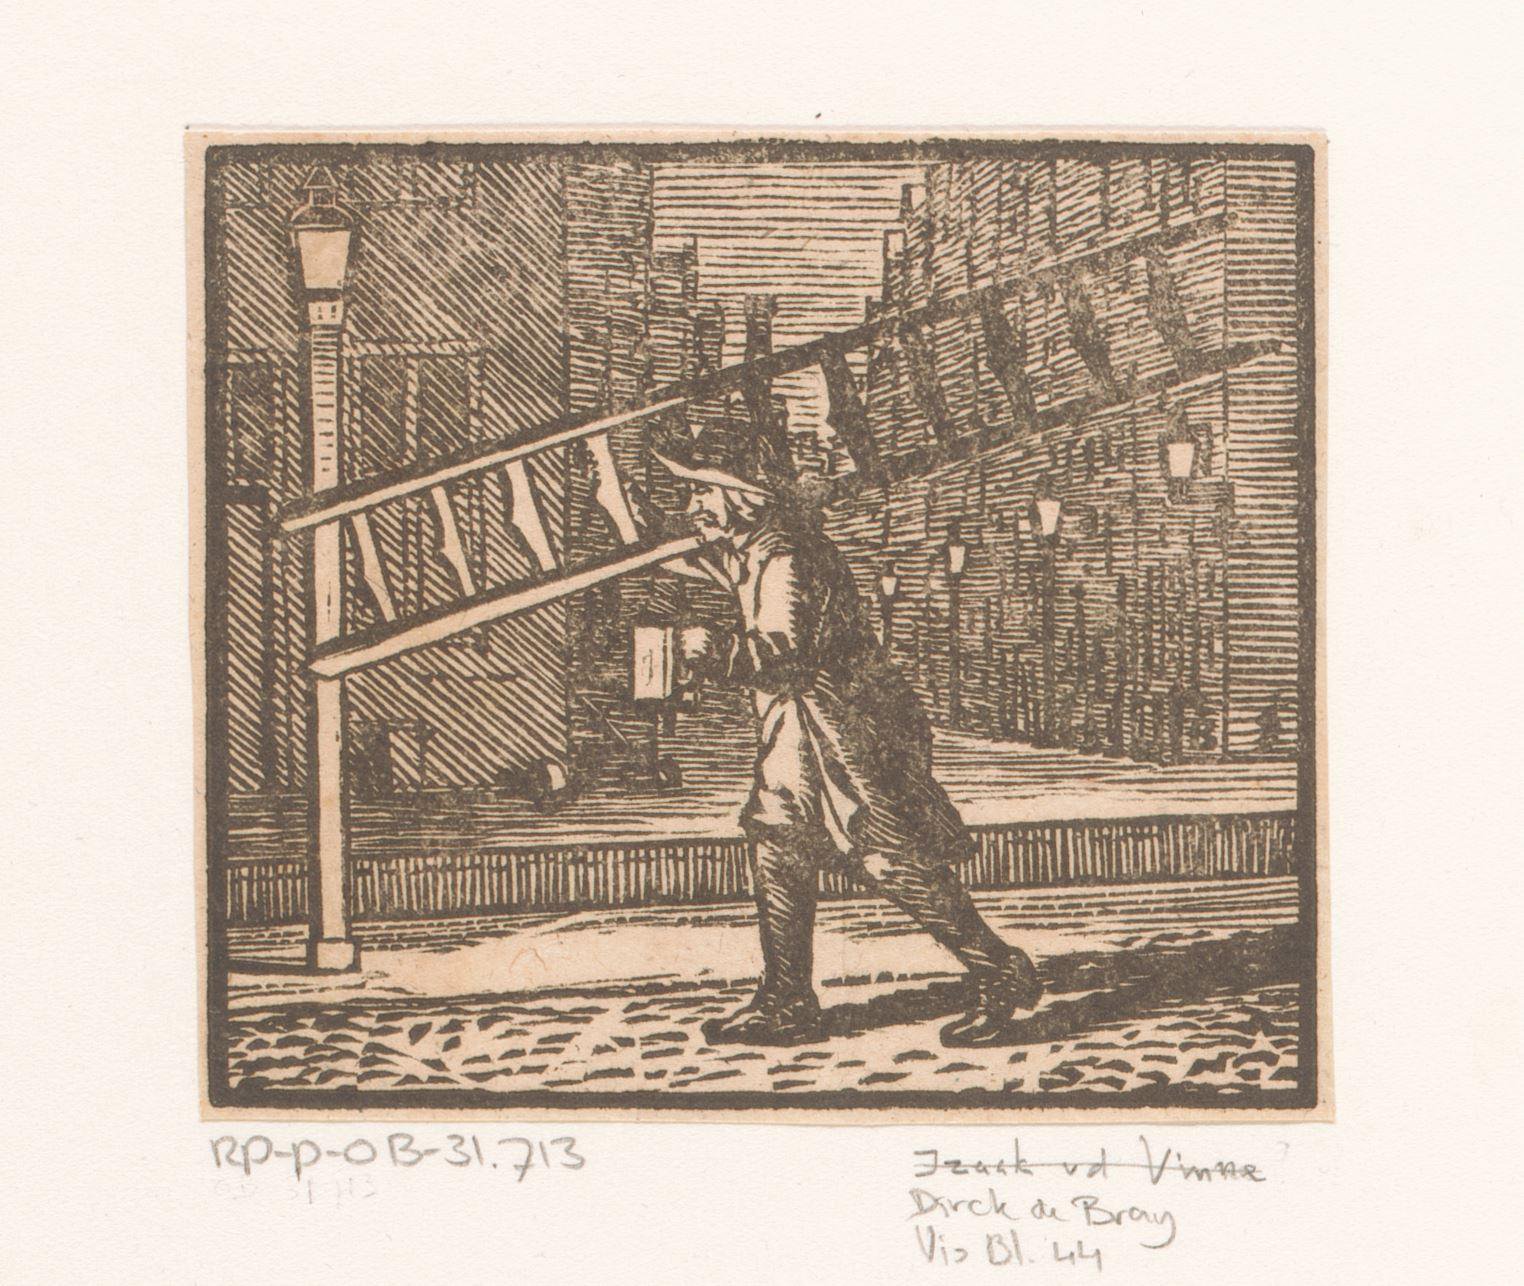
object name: print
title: Lantaarnopsteker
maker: dirck de bray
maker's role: draughtsman, painter, print maker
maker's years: 1625-1694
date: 1635-1694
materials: paper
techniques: woodcut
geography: netherlands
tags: oil-lamp (+ kindling a light; lit, burning light, lamp, candle), ladder, street lighting, street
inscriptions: collector's mark: Lugt 2228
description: Een lantaarnopsteker loopt door de straten met een ladder op zijn schouder en een lantaarn in zijn hand.